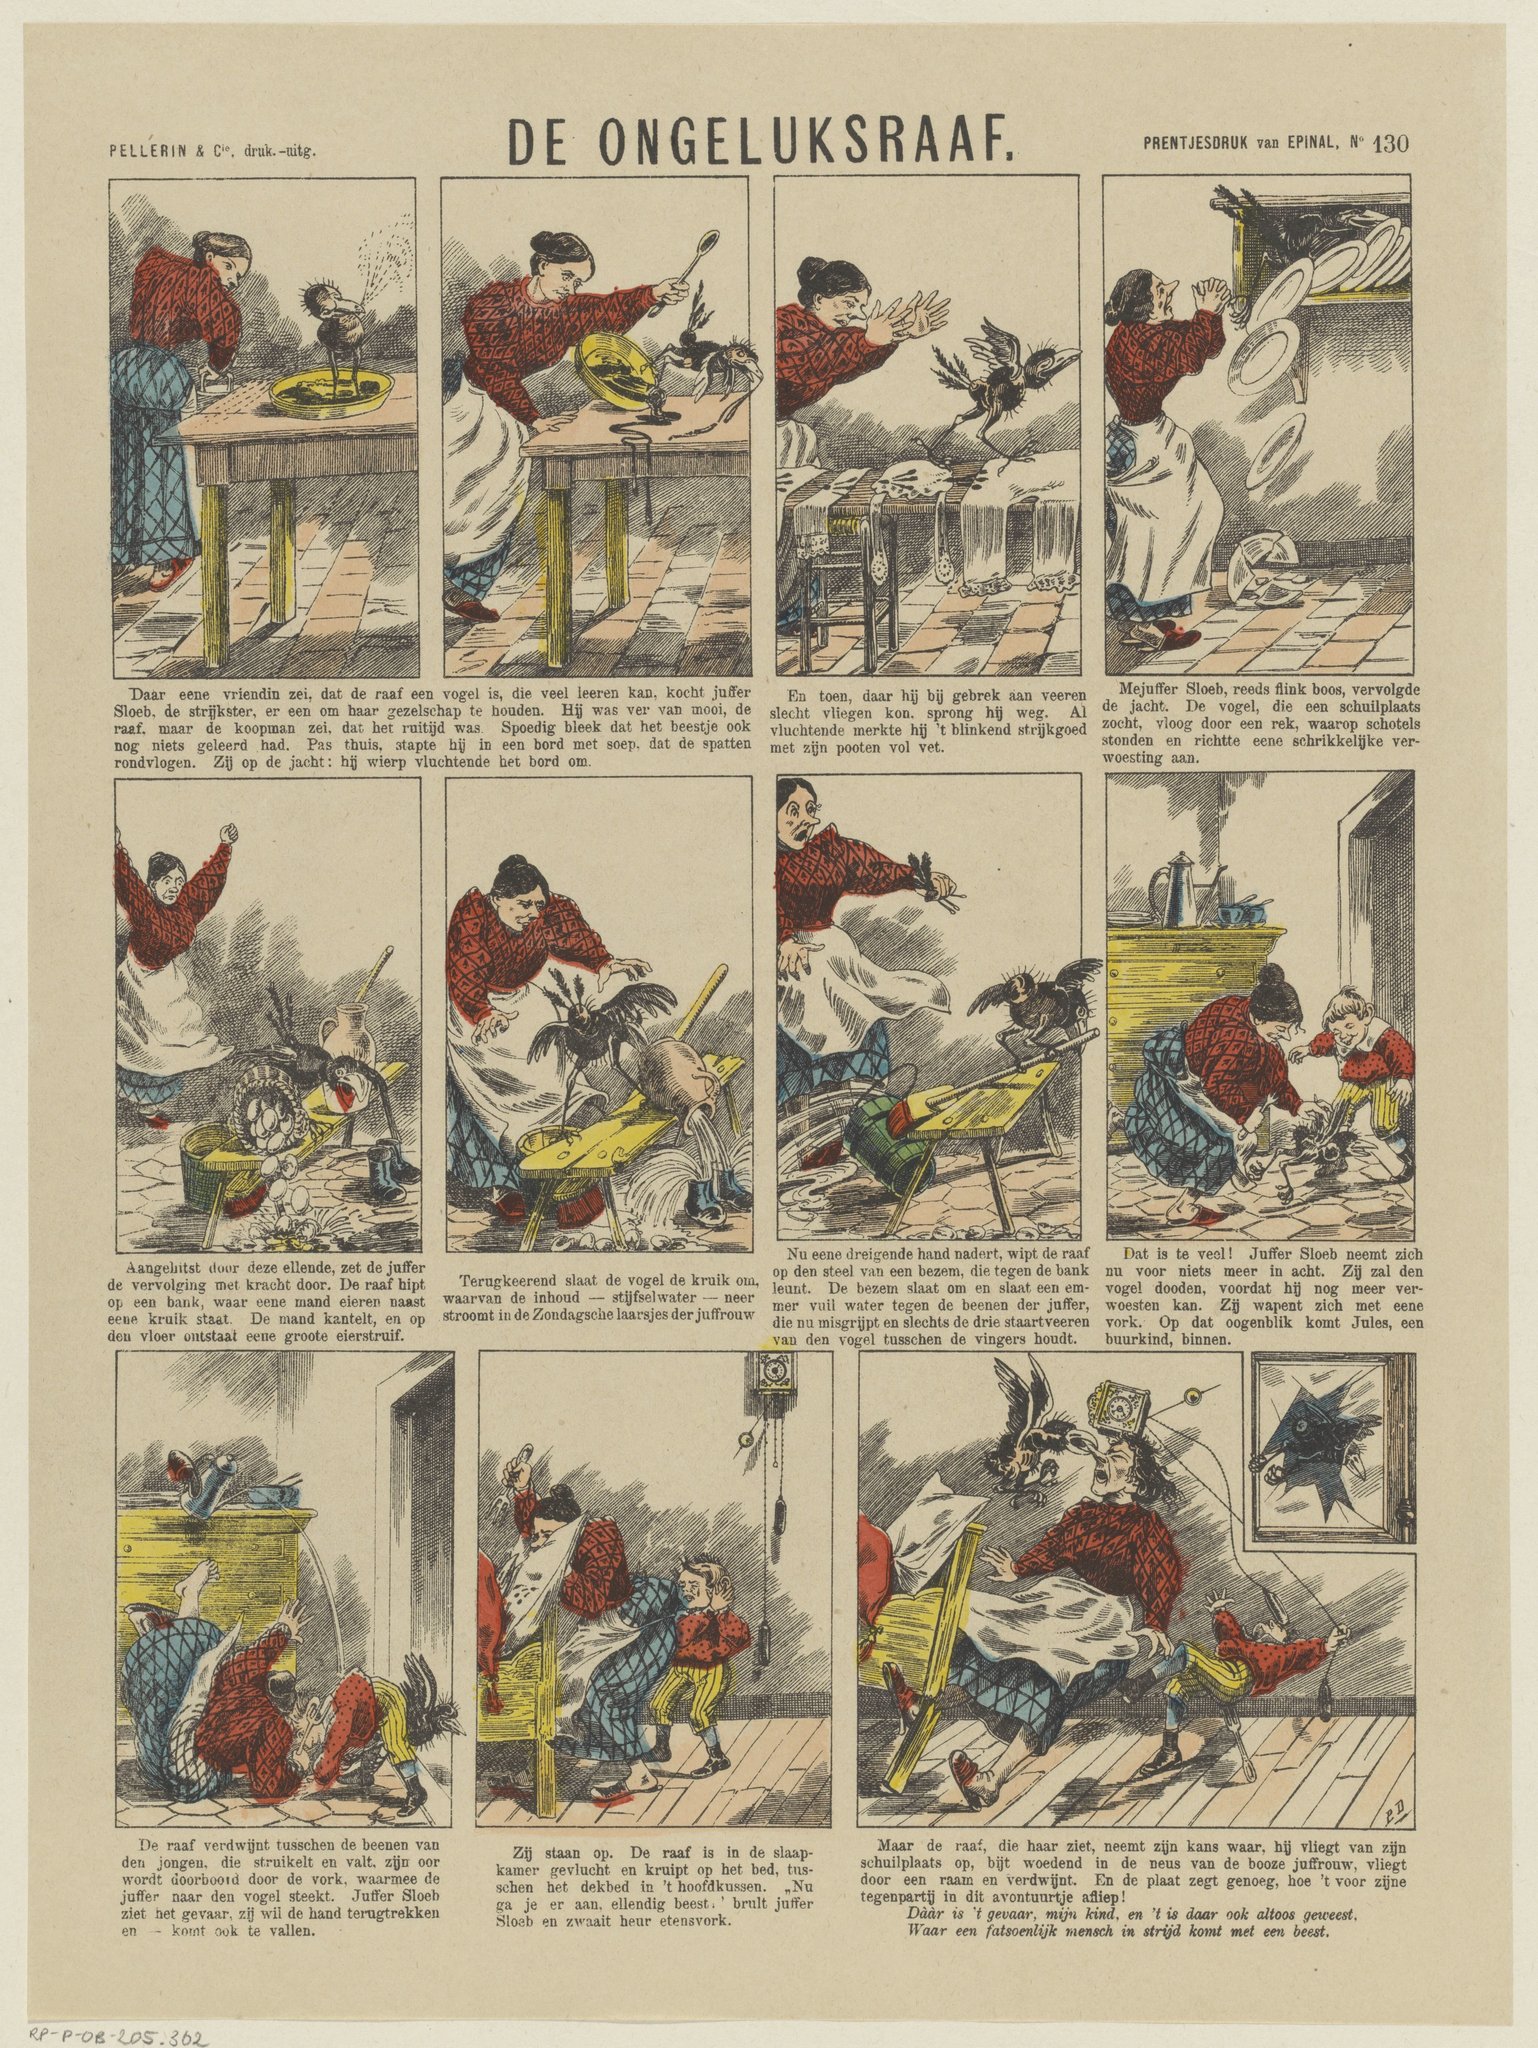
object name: print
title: De ongeluksraaf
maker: monogrammist pd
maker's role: print maker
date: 1902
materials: paper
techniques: colour, letterpress printing, lithograph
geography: epinal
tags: song-birds: raven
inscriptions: collector's mark: Lugt 2760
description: Blad met 11 voorstellingen over Juffrouw Sloeb die een lelijke en ongehoorzame raaf heeft gekocht, die alles stuk maakt wat er op zijn pad komt. Onder elke afbeelding een onderschrift. Genummerd rechtsboven: No 130.